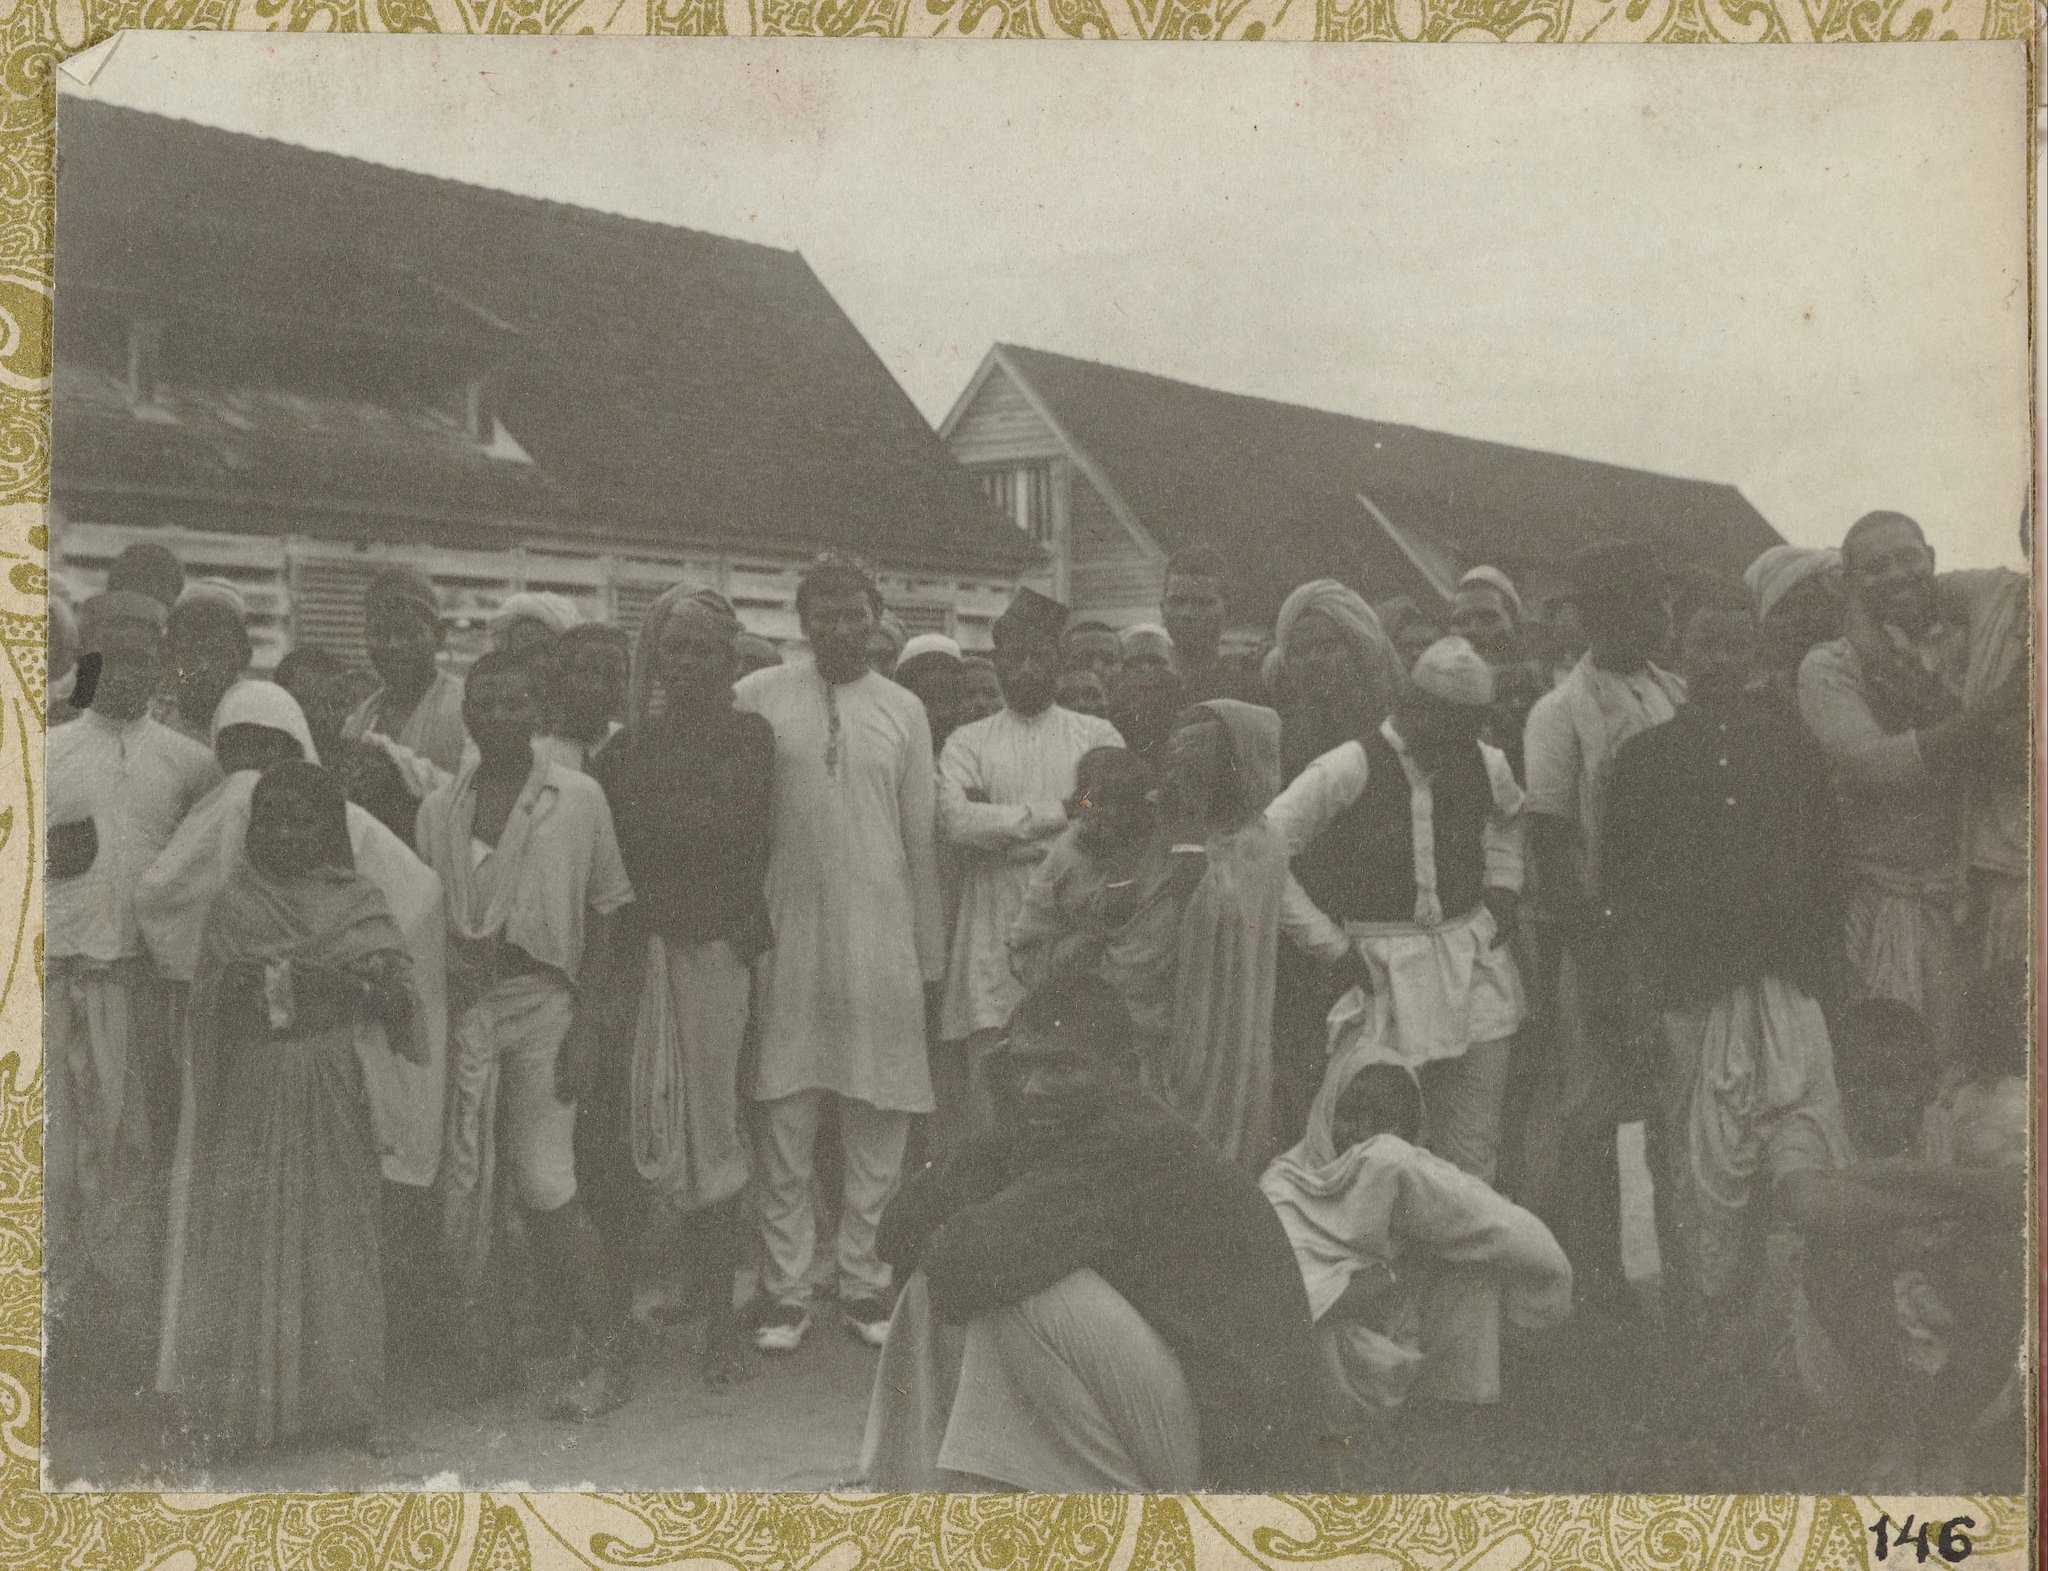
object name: photograph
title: Menigte op straat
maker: hendrik doijer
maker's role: engineer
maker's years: 1863-1925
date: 1903-1910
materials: photographic support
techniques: gelatin silver print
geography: suriname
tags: suriname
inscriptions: inscription: ‘146’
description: Een groep van mensen, staand en zittend wachtend op straat. Onderdeel van het fotoalbum Souvenir de Voyage (deel 2), over het leven van de familie Doijer in en rond de plantage Ma Retraite in Suriname in de jaren 1903-1910.